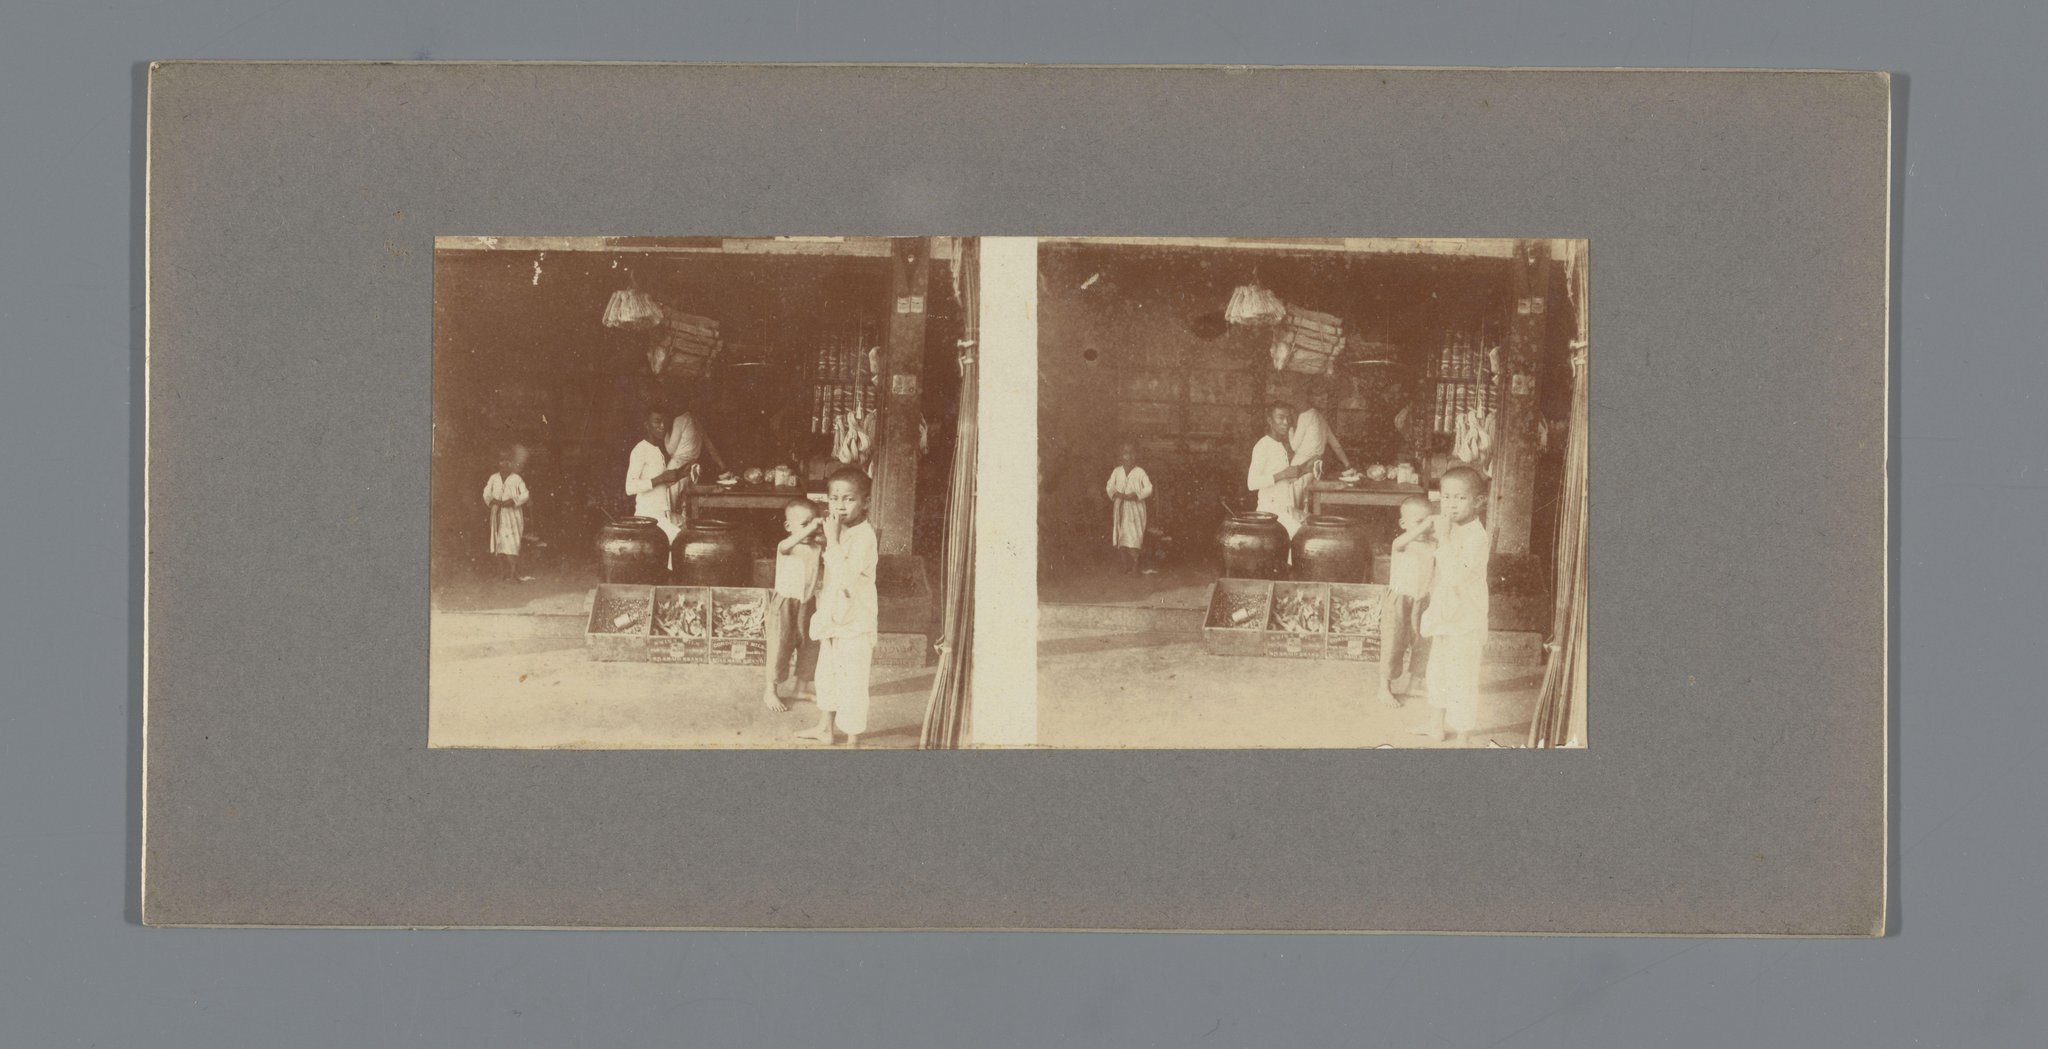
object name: stereograph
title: Kruidenier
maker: robert julius boers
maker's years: 1867-1932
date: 1900-1922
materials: cardboard, photographic support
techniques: gelatin silver print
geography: bangka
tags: robert julius boers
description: Kruidenier te Soengeiliat op Banka. Onderdeel van een groep stereofoto's van Robert Julius Boers, chef van het staatsbedrijf de Banka-tinwinning op Banka, uit de periode ca. 1900-1922.